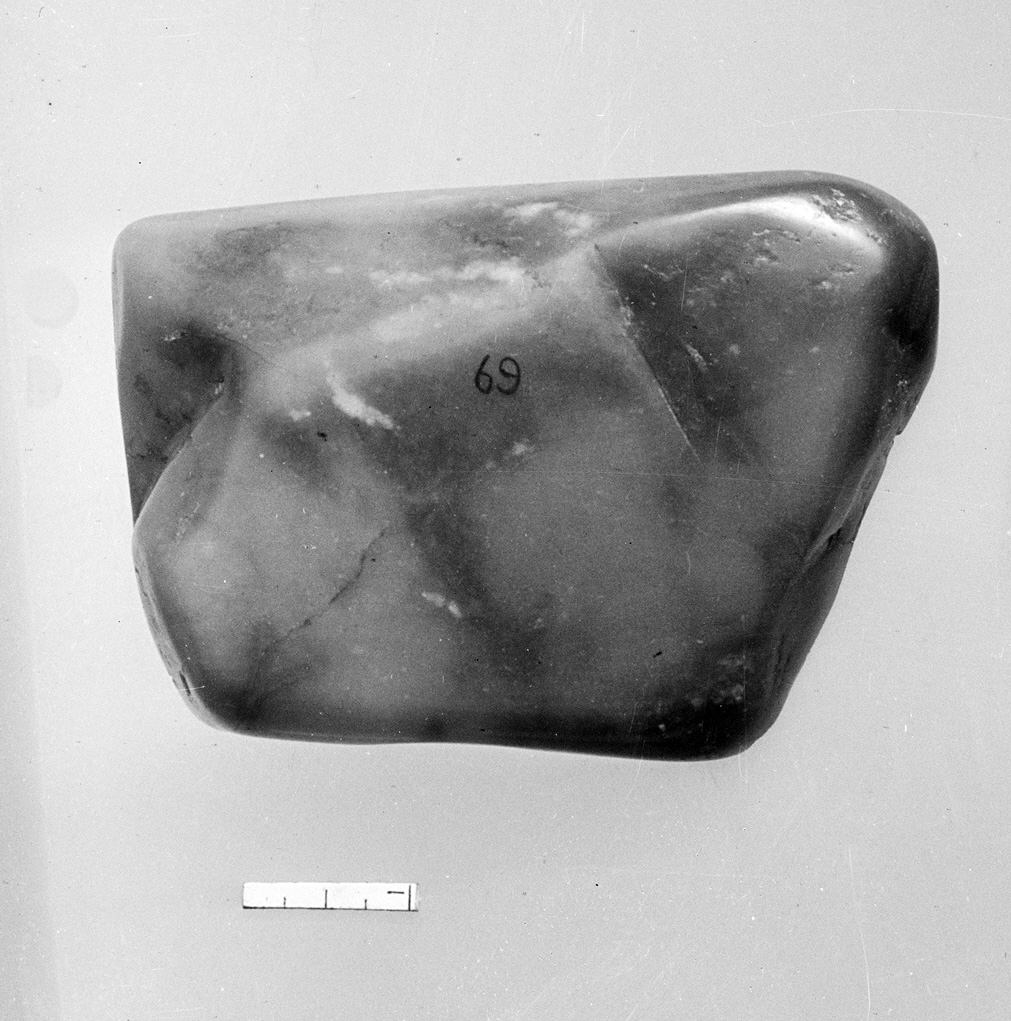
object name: fragment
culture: chinese or turkestani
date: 1902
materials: jade